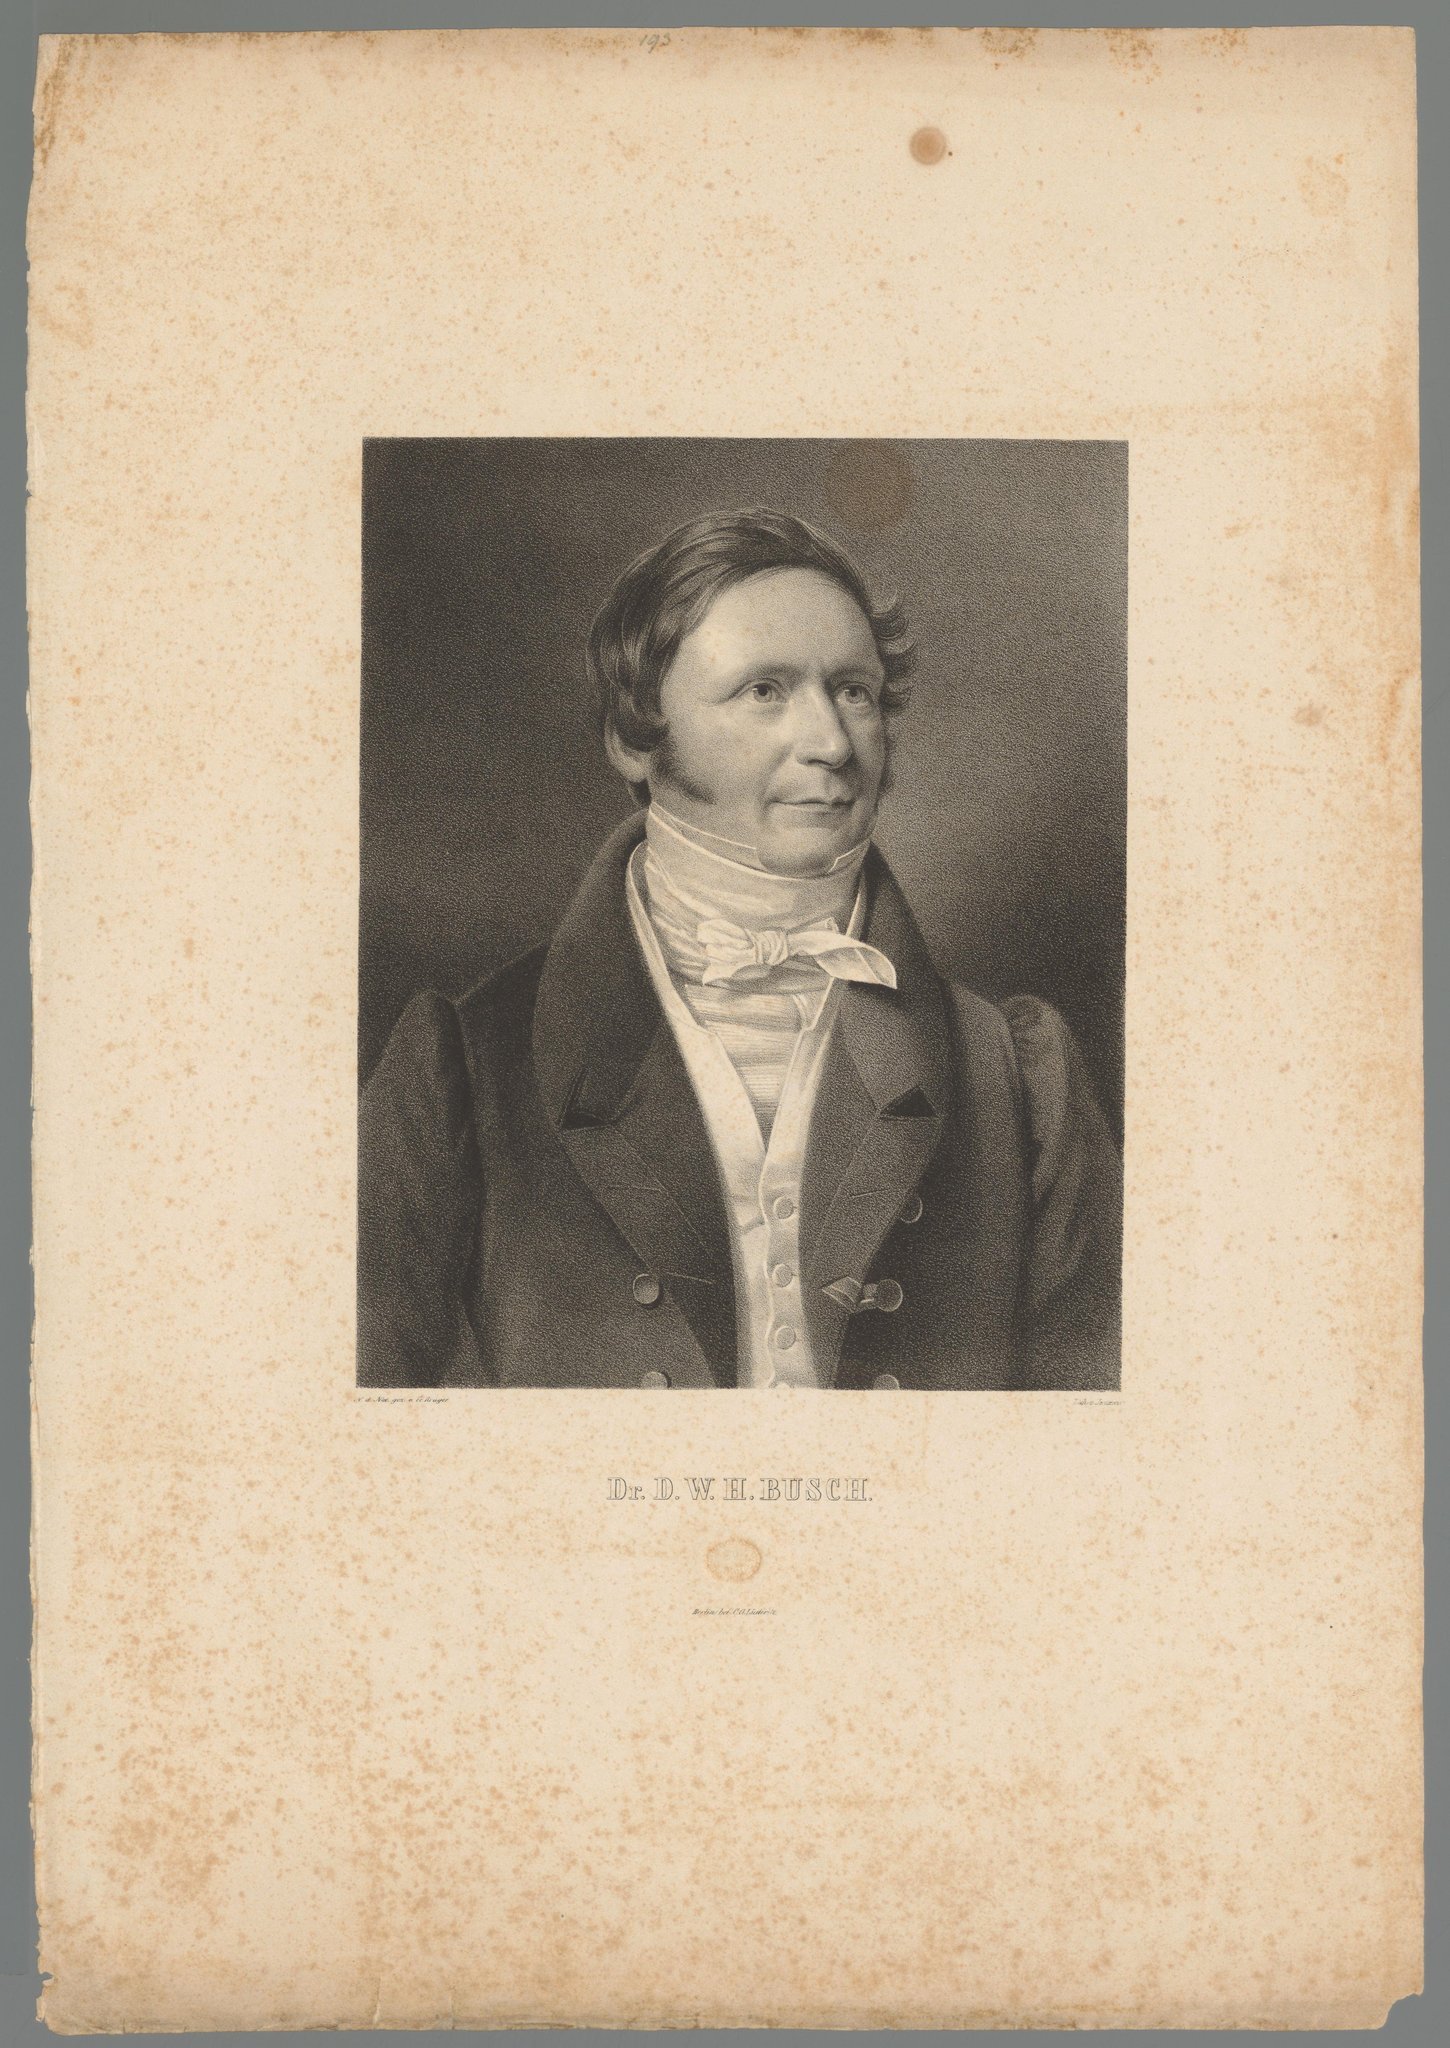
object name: print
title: Portret van Dietrich Wilhelm Heinrich Busch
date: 1814-1837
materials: paper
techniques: lithograph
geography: berlin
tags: adult man, historical persons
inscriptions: check stamp: Lugt 4519, collector's mark: Lugt 2228